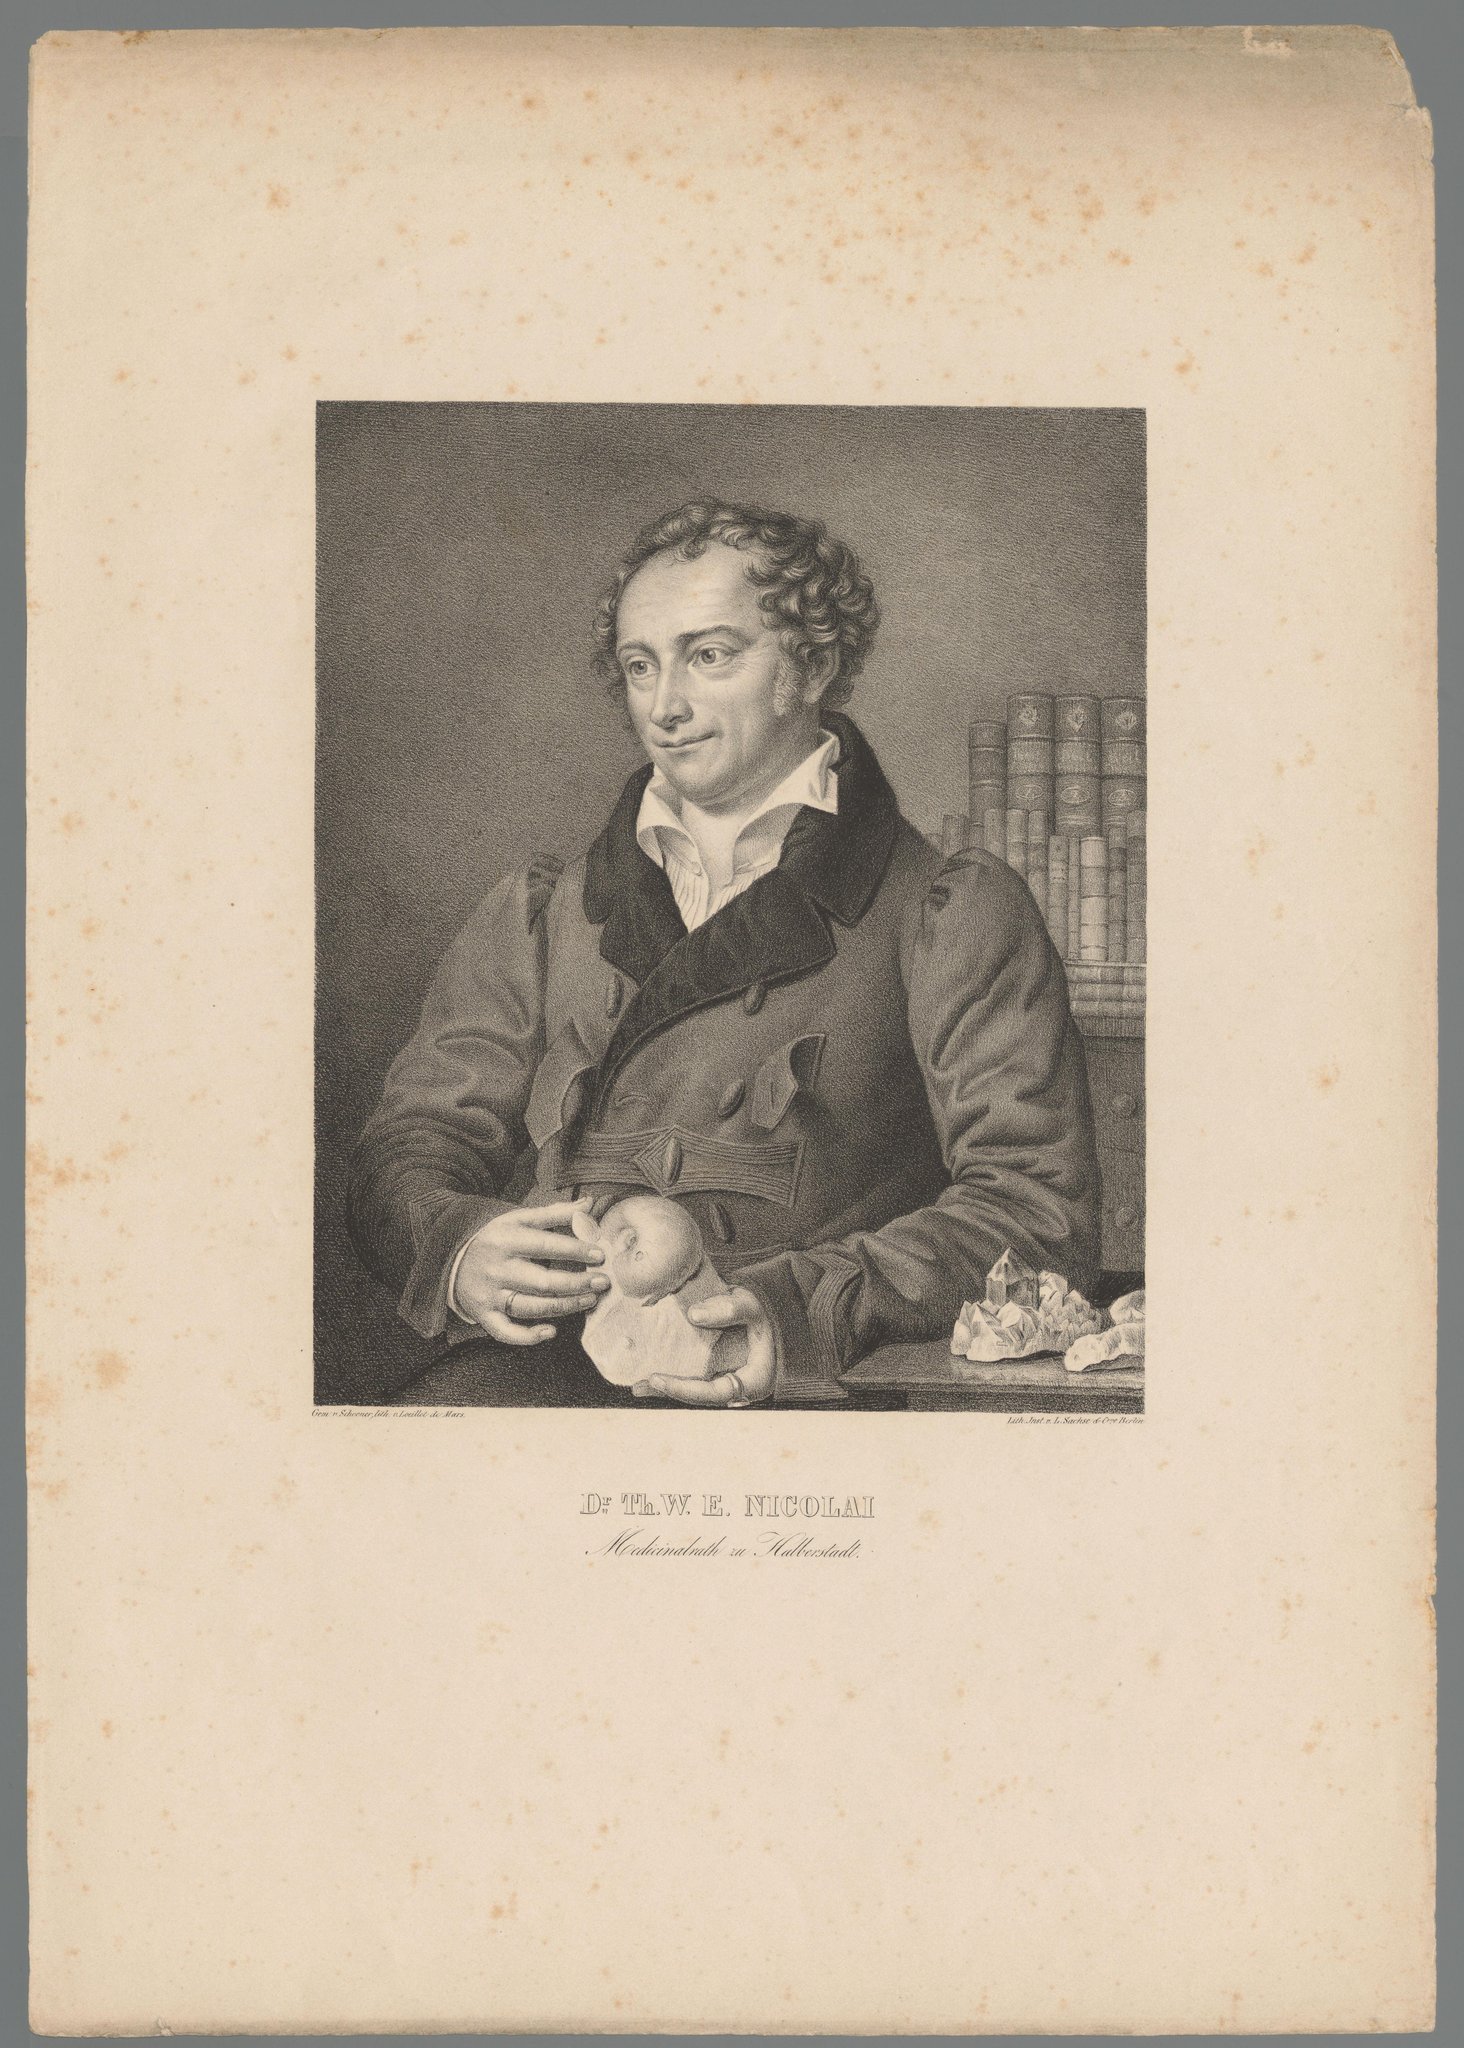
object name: print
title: Portret van Theodor Wilhelm Emanuel Nicolai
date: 1832-1871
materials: paper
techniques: lithograph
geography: berlin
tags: historical persons not known by name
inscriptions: collector's mark: Lugt 2228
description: Portret van een verder onbekende man met de naam Theodor Wilhelm Emanuel Nicolai, mogelijk een mineraloog.